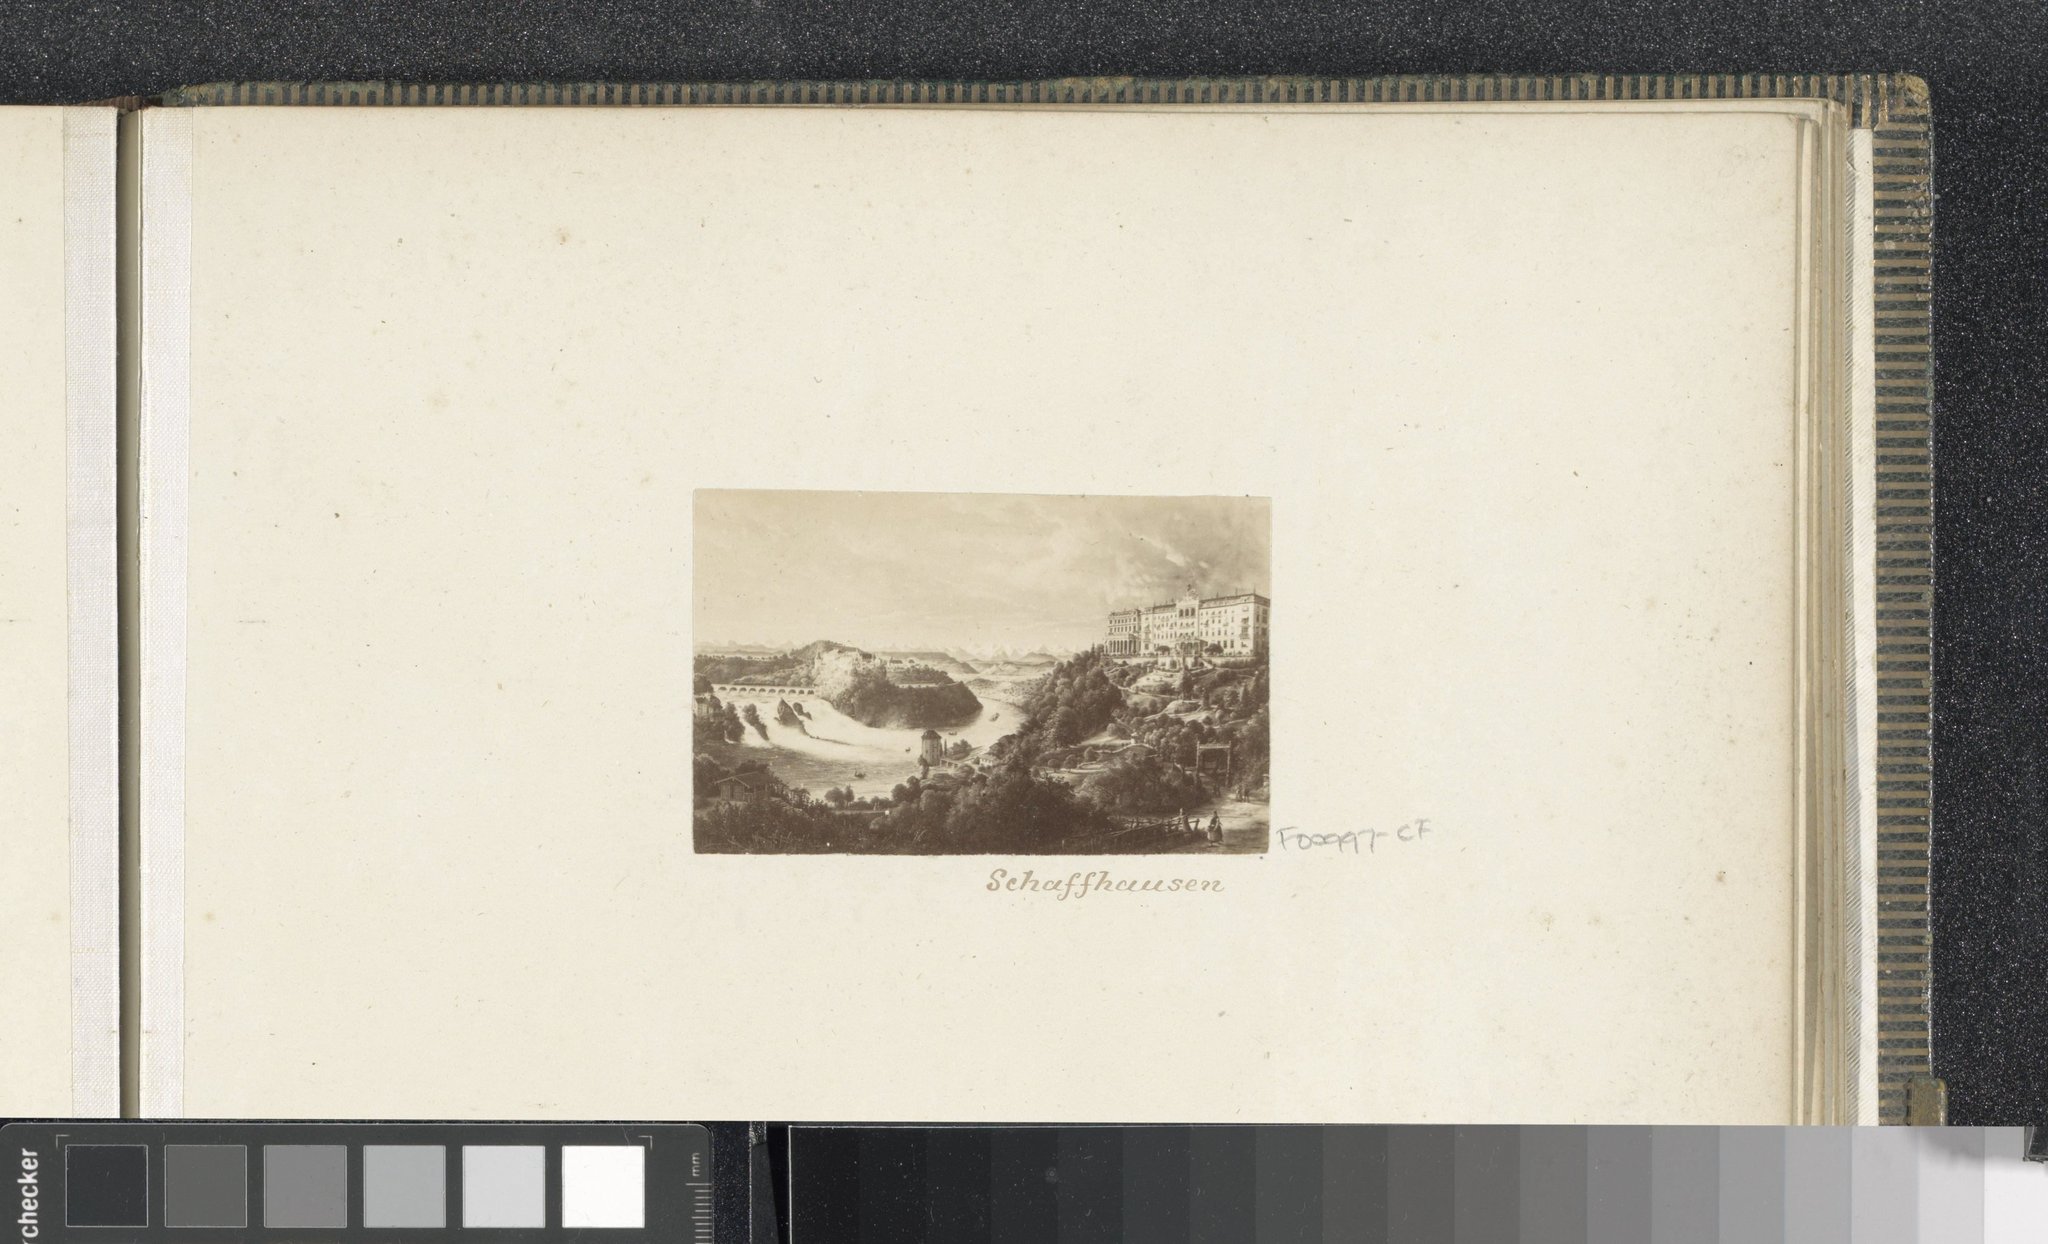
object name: photograph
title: Schaffhausen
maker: Anonymous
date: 1860-1890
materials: paper, photographic support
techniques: albumen print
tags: waterfall (+ landscape with figures, staffage)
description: Onderdeel van Reisalbum met foto's van Zwitserland, Oostenrijk, Italië en Duitsland.